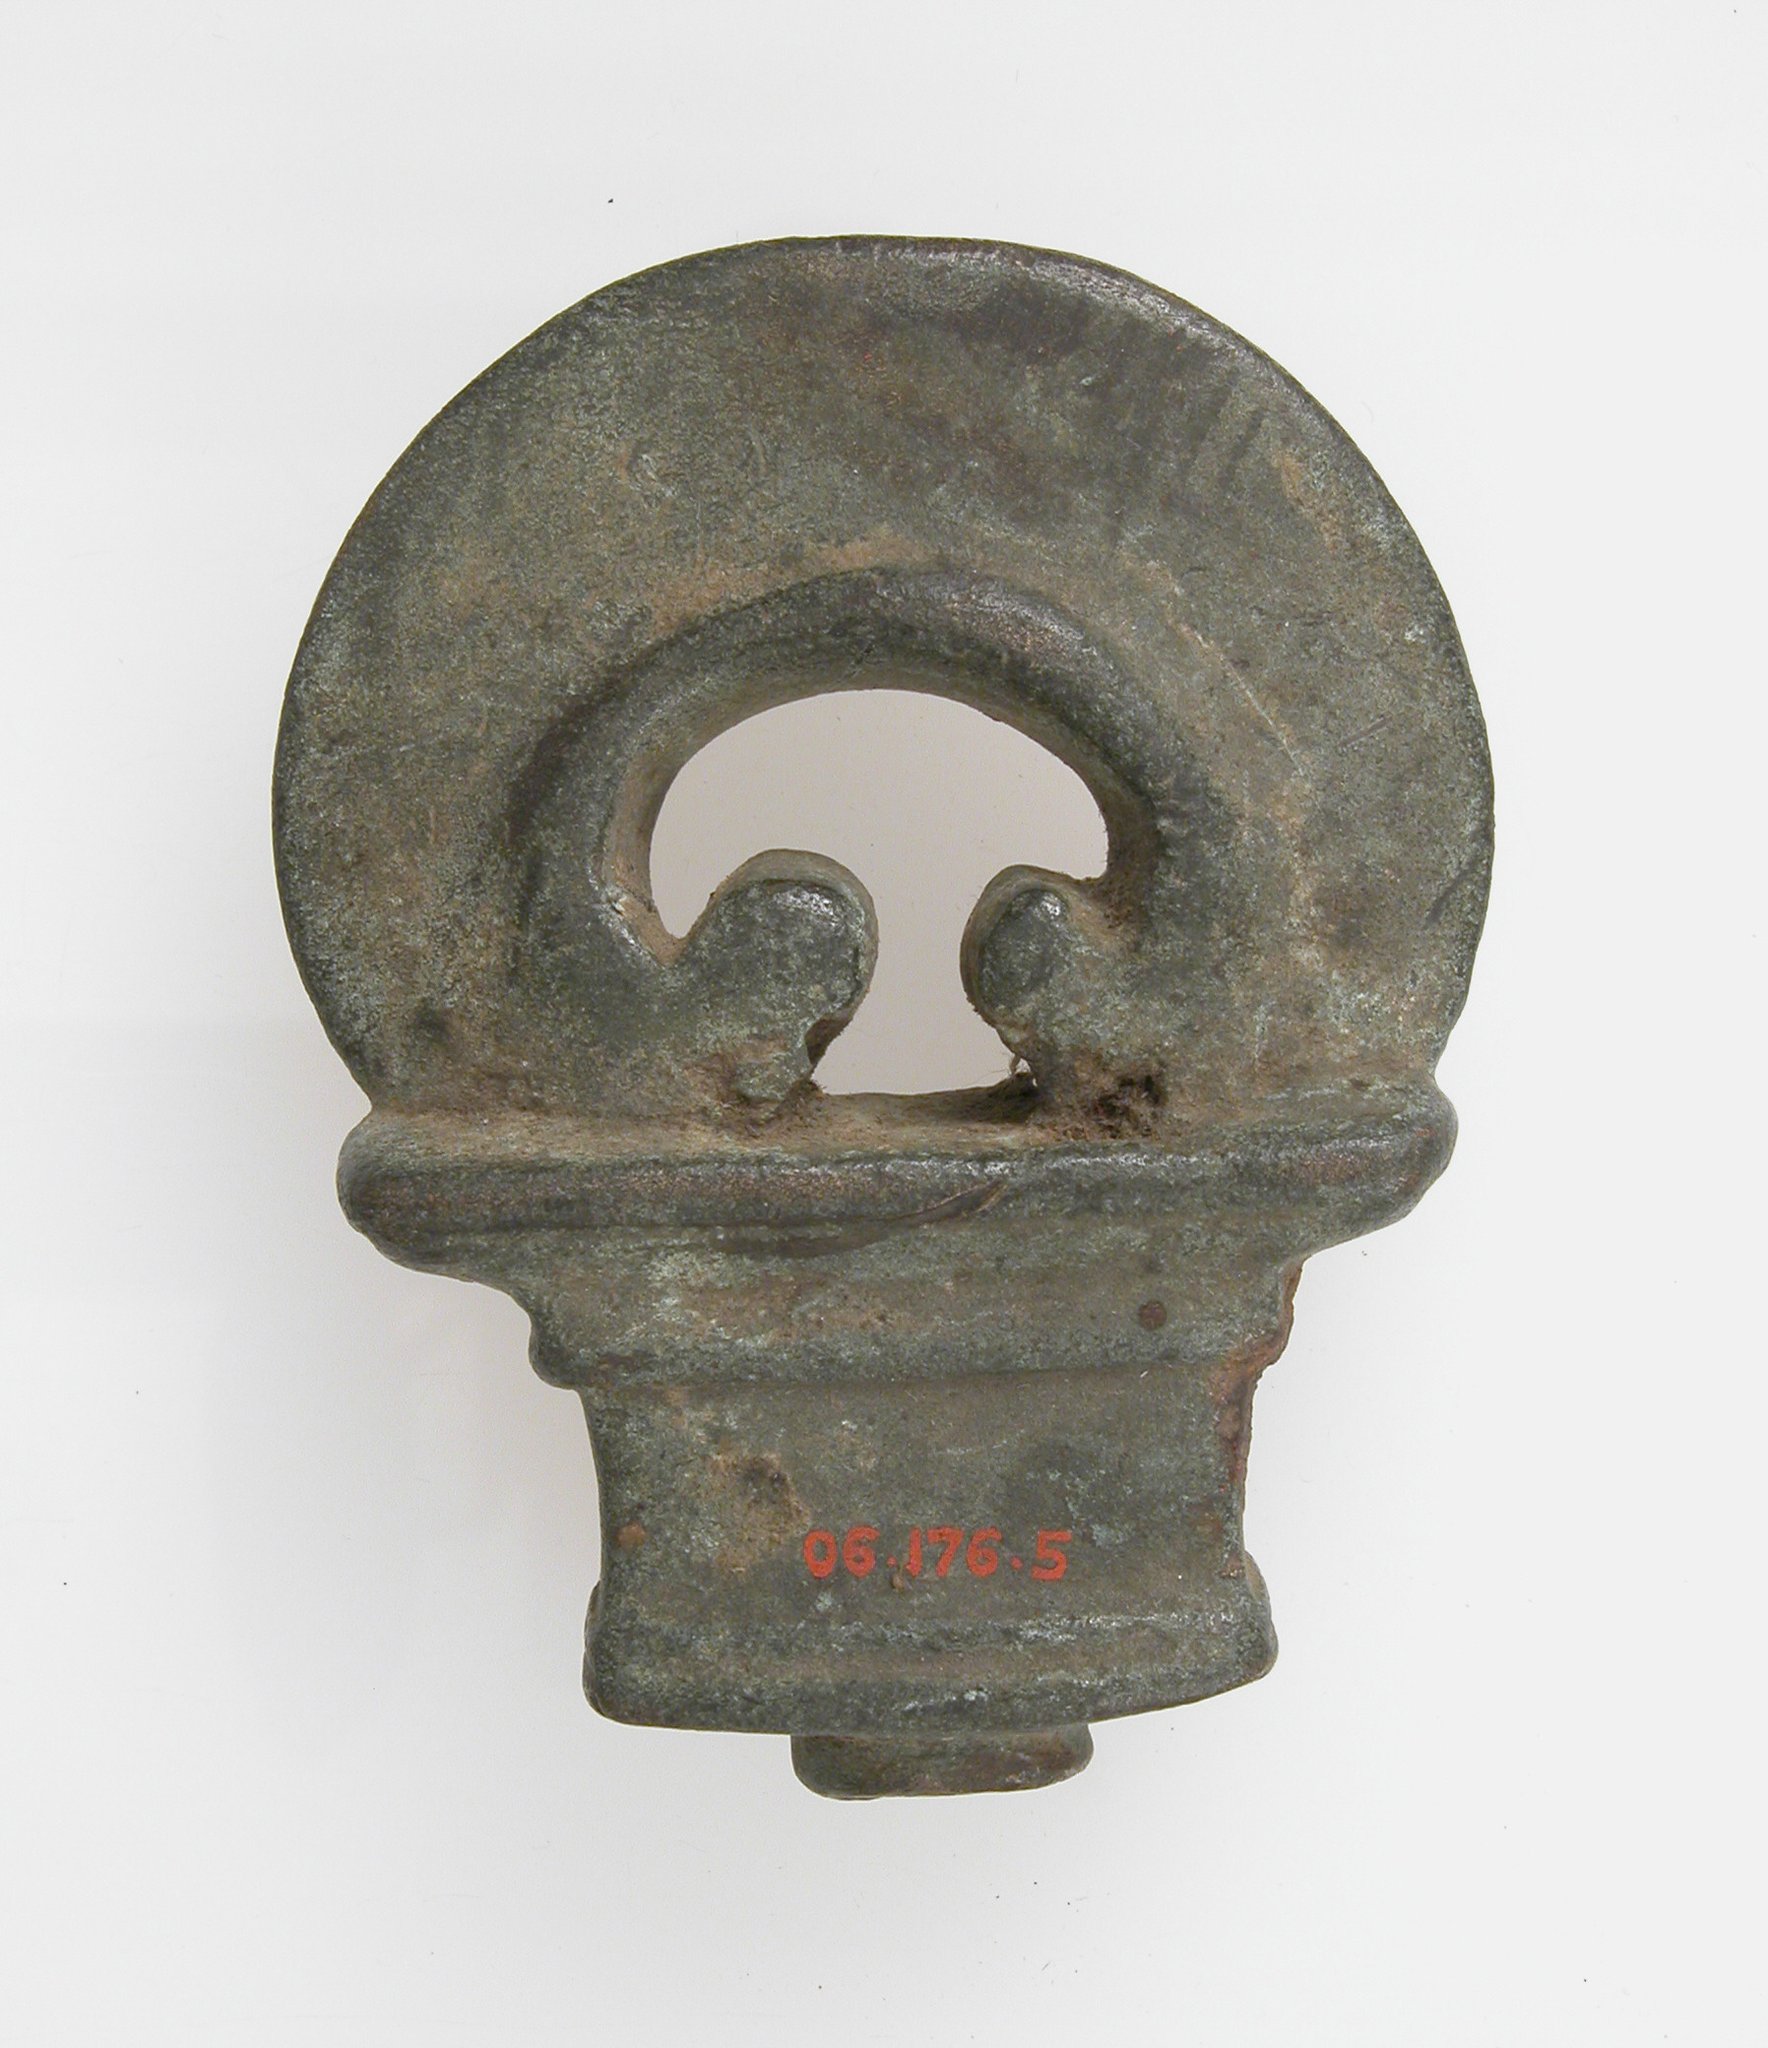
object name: key handle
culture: roman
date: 1-700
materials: copper alloy